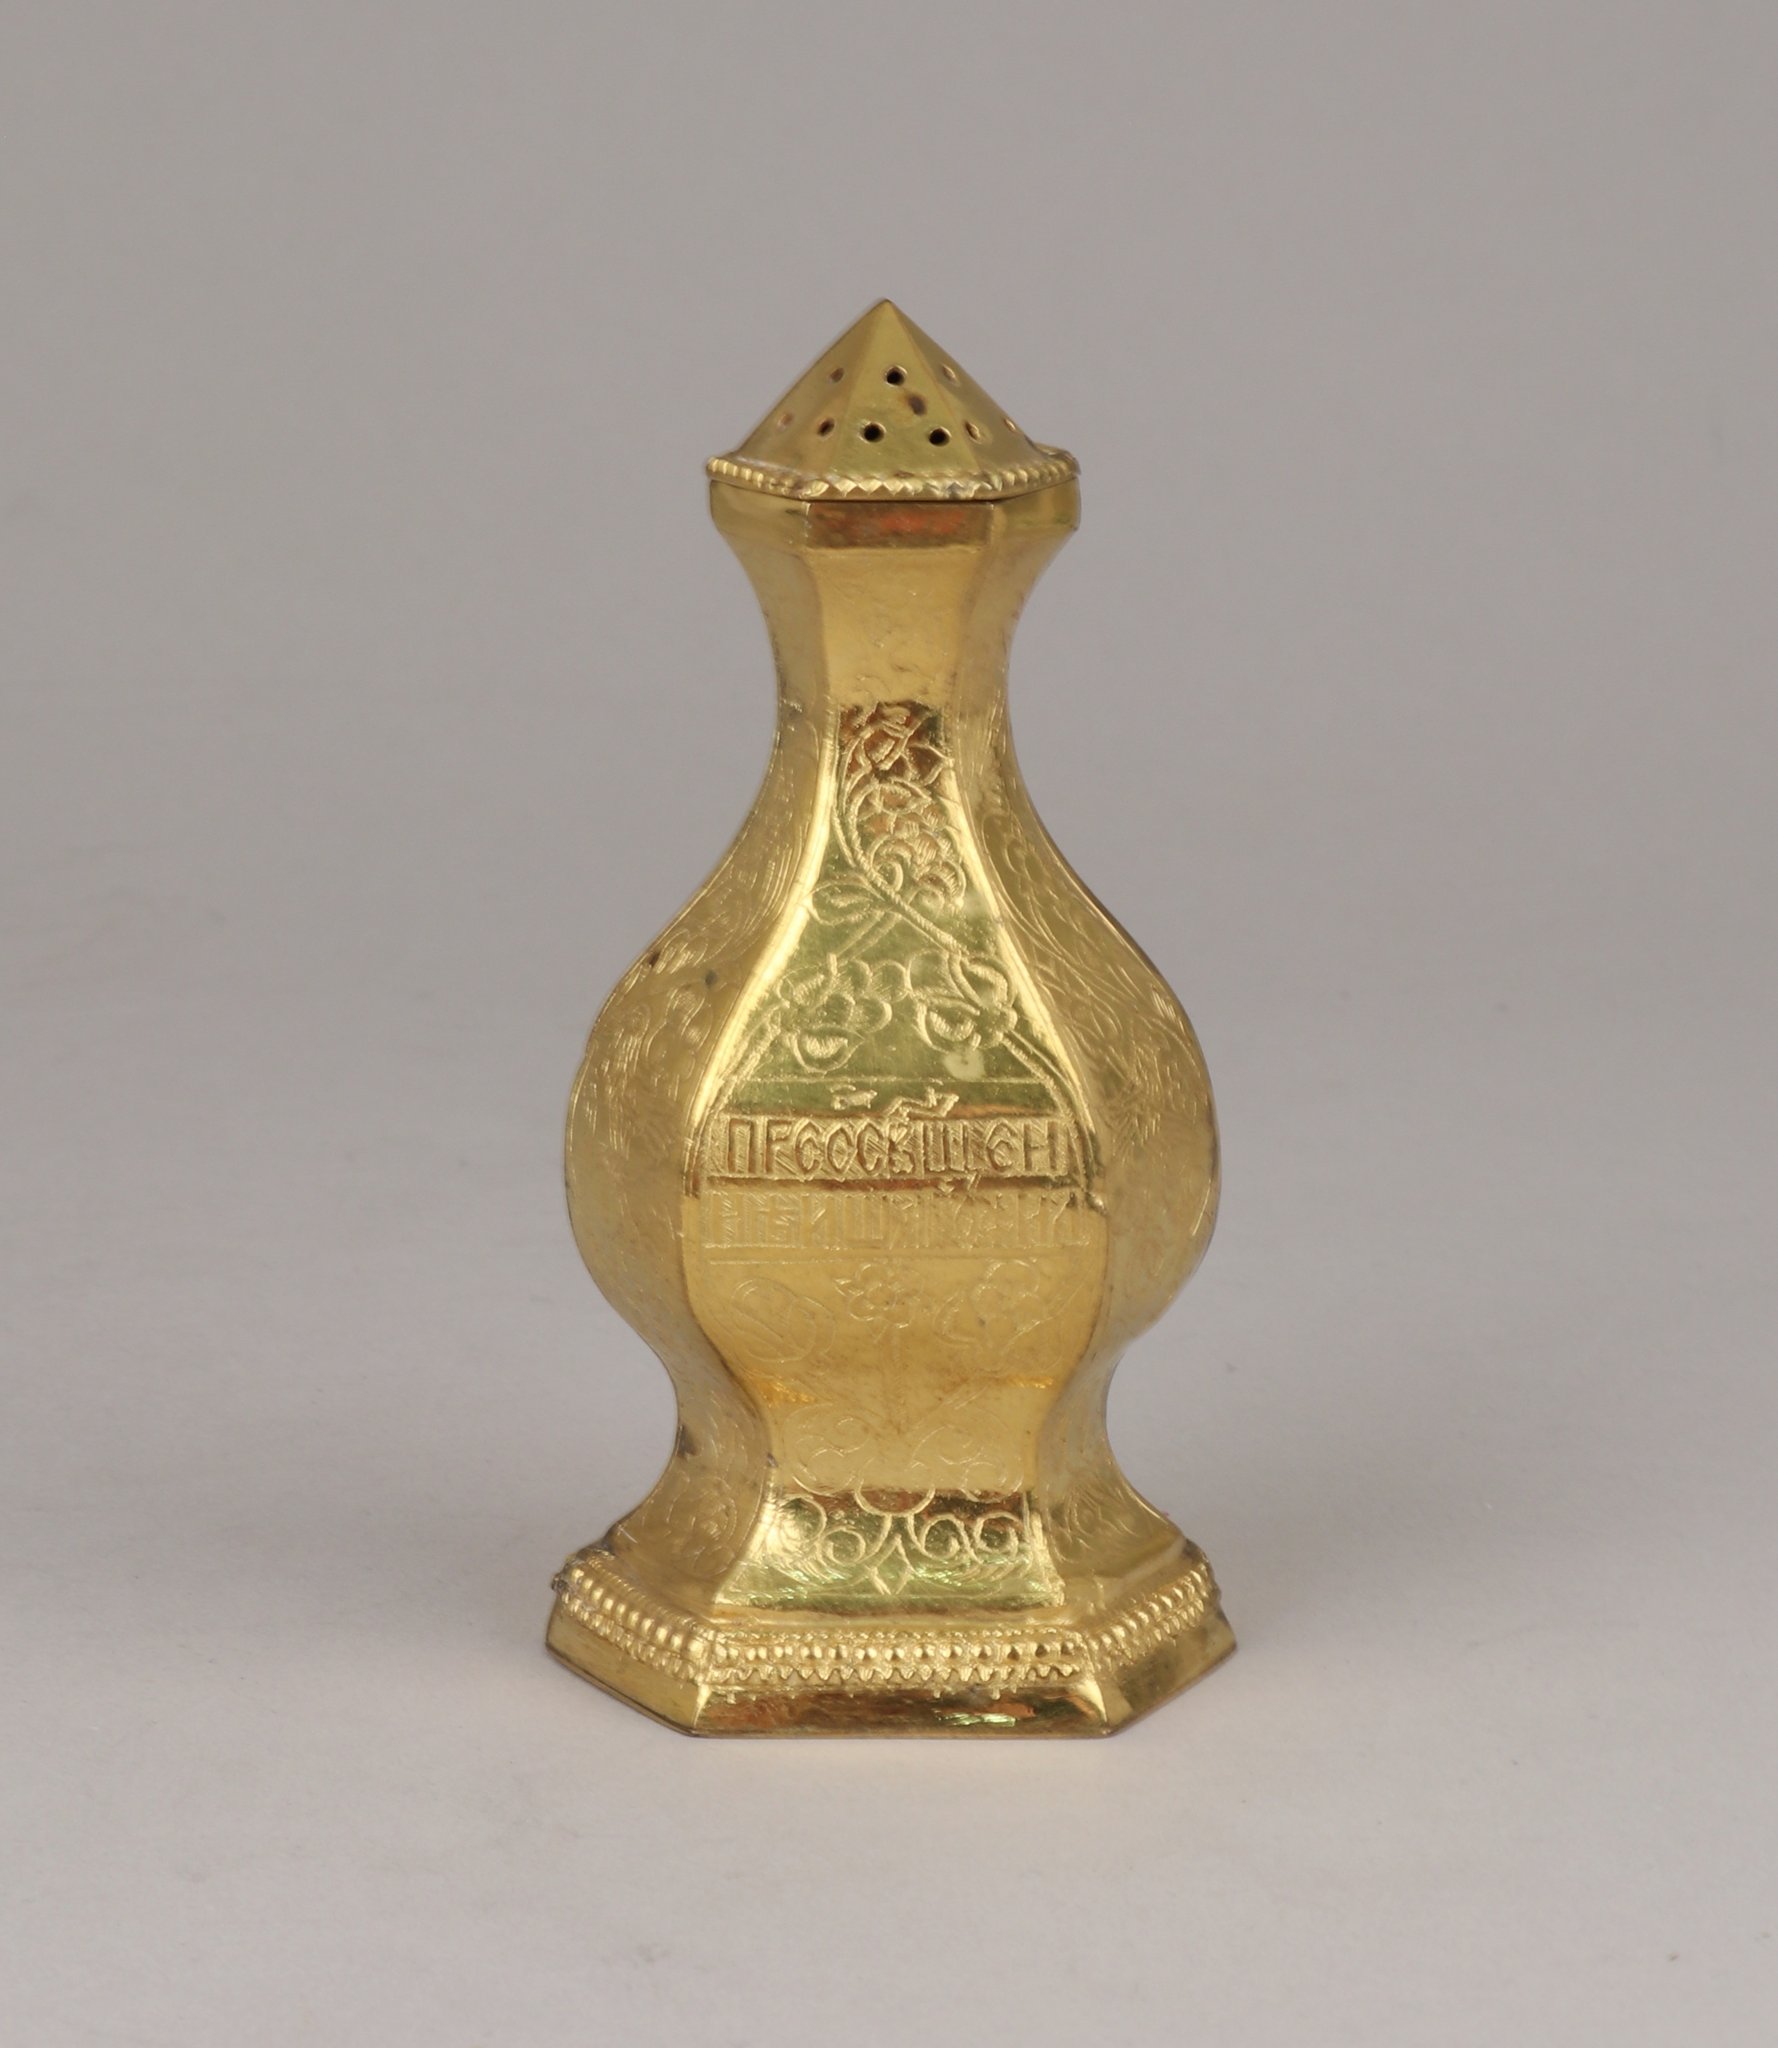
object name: pepper caster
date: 1801-1900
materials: metal, silver